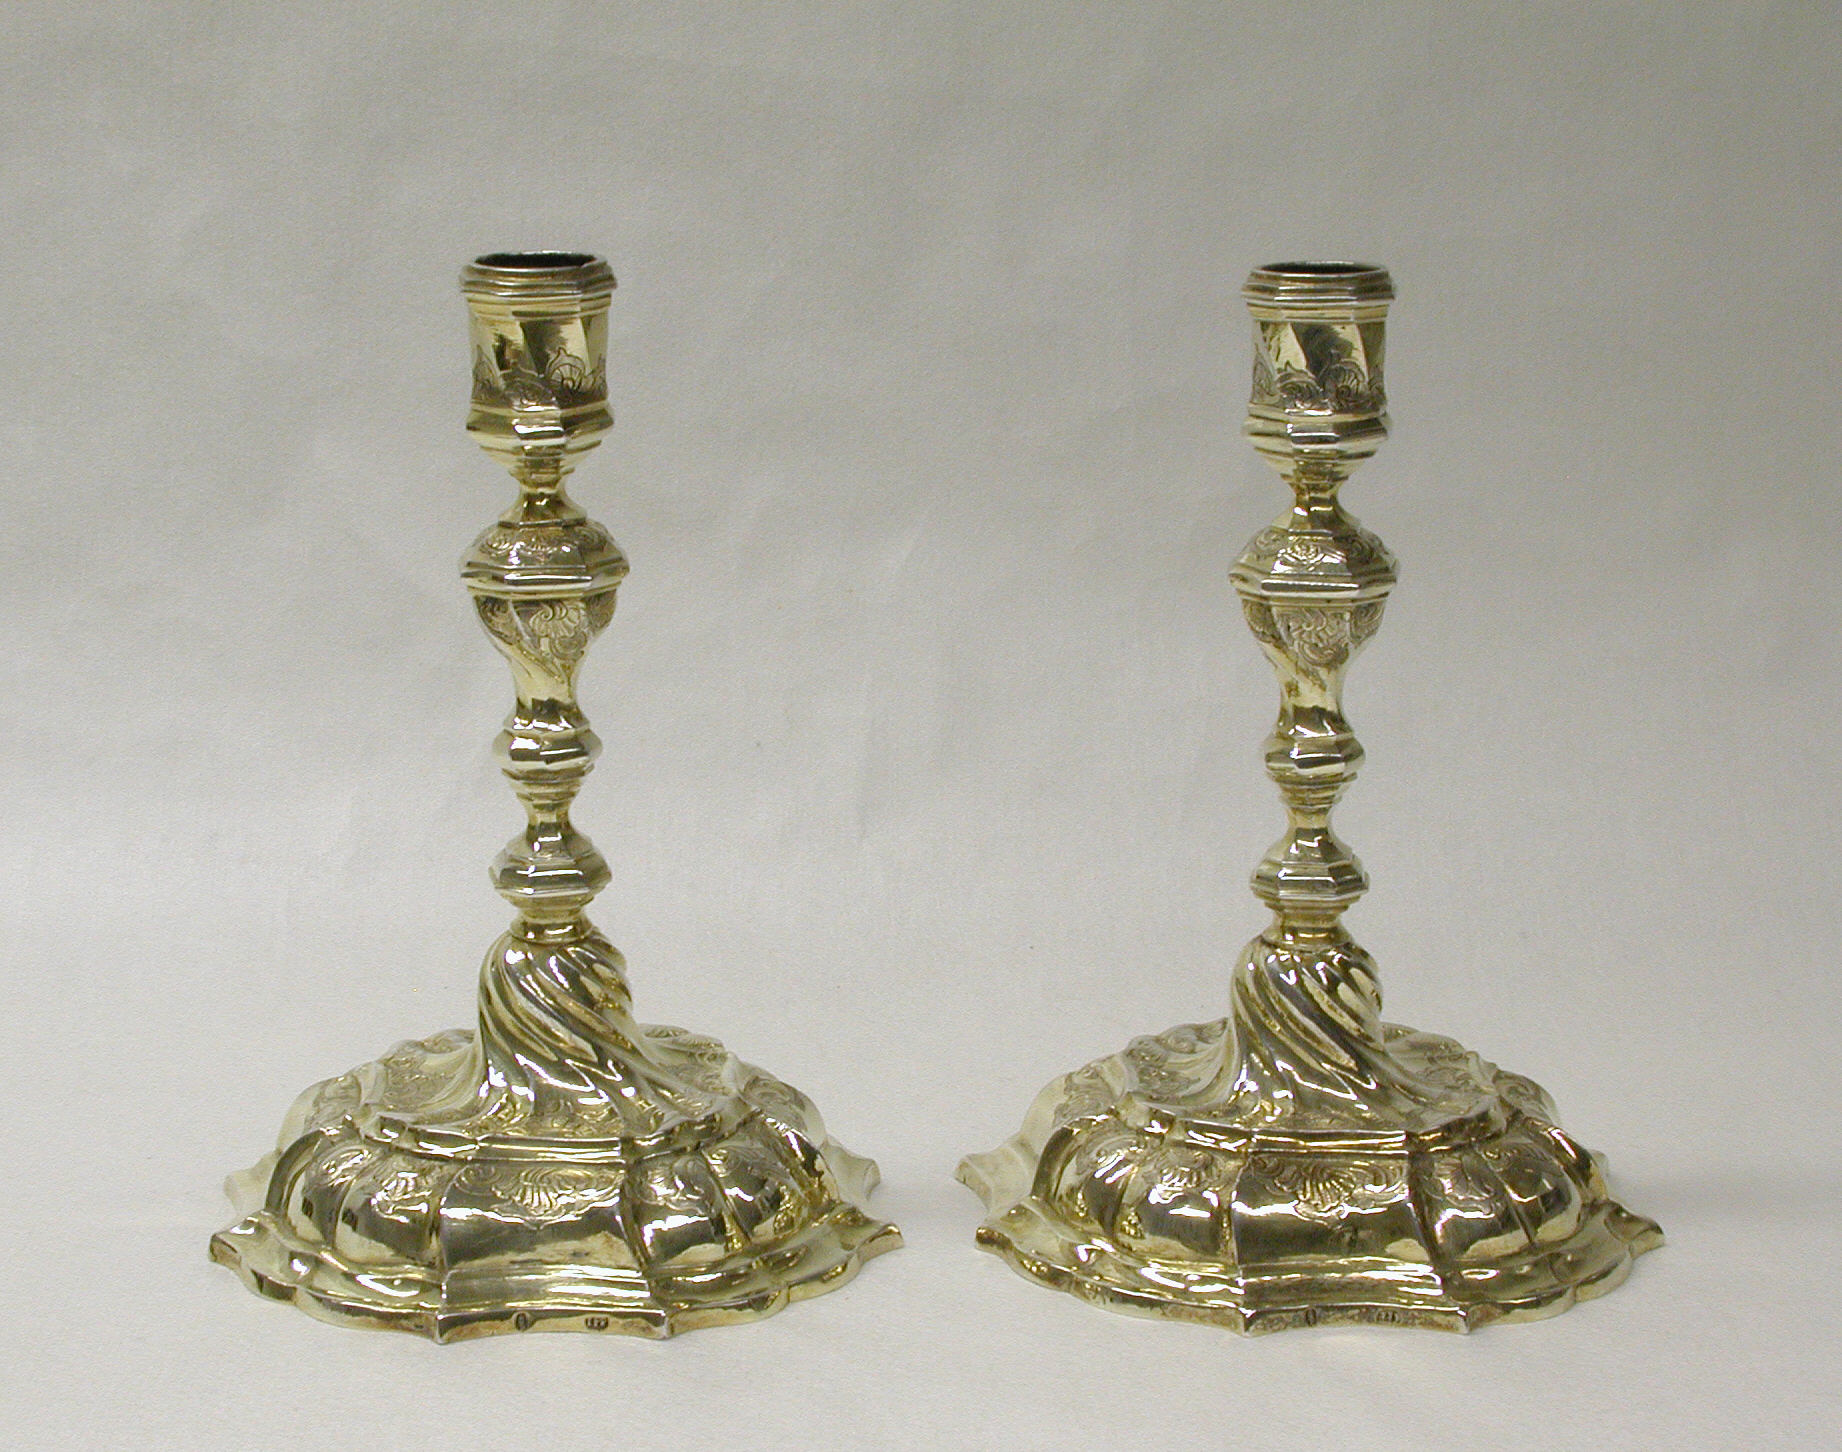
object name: candlestick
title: Candlestick (one of a pair)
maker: johann peter pepfenhauser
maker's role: maker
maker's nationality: german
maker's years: 1738-1747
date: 1743-1745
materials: silver gilt